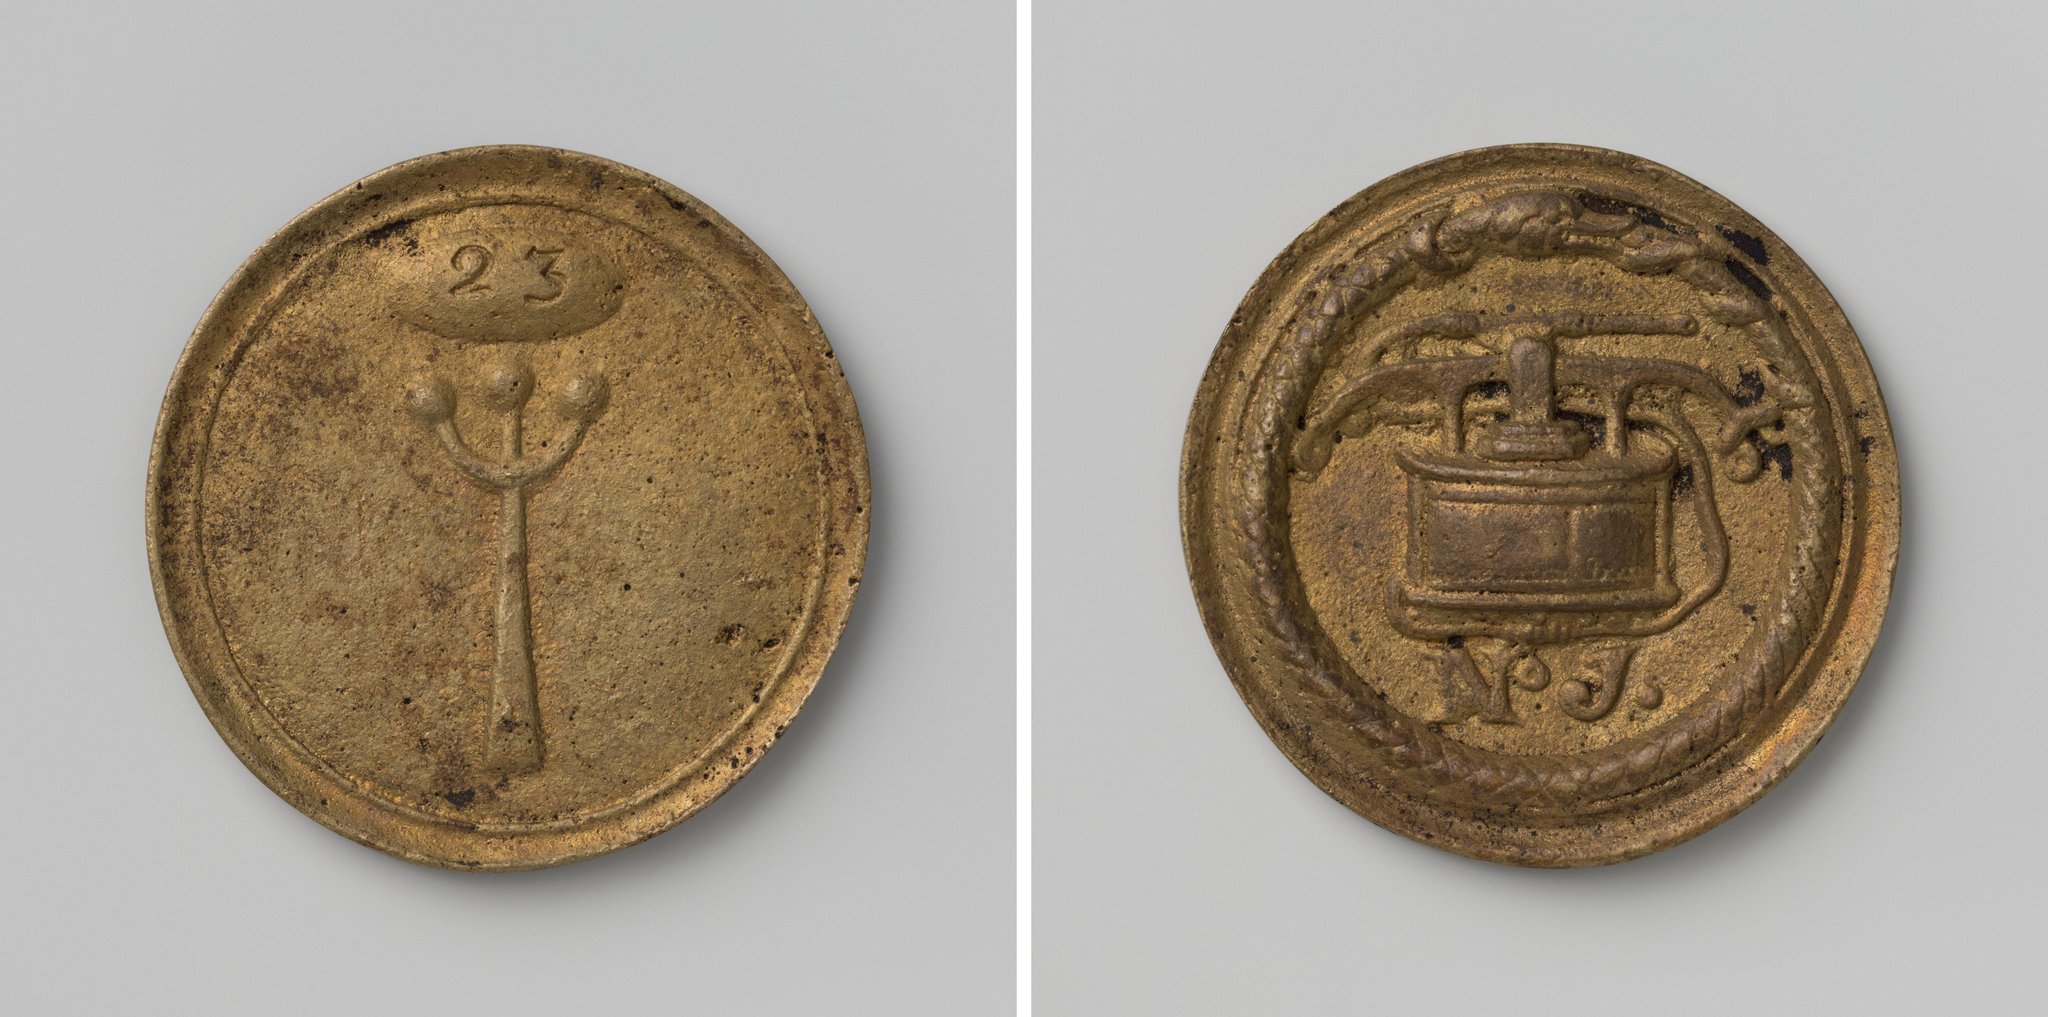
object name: fire engine medal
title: Oostzaan, brandspuitpenning van spuit 1 met no. 23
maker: Anonymous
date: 1680-1800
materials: brass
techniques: casting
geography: oostzaan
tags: oostzaan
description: Messing penning. Voorzijde: drietandige hooivork met daarop drie kaarsjes onder een compartiment met no. 23. Keerzijde: brandspuit boven opschrift No. 1 binnen slangerond